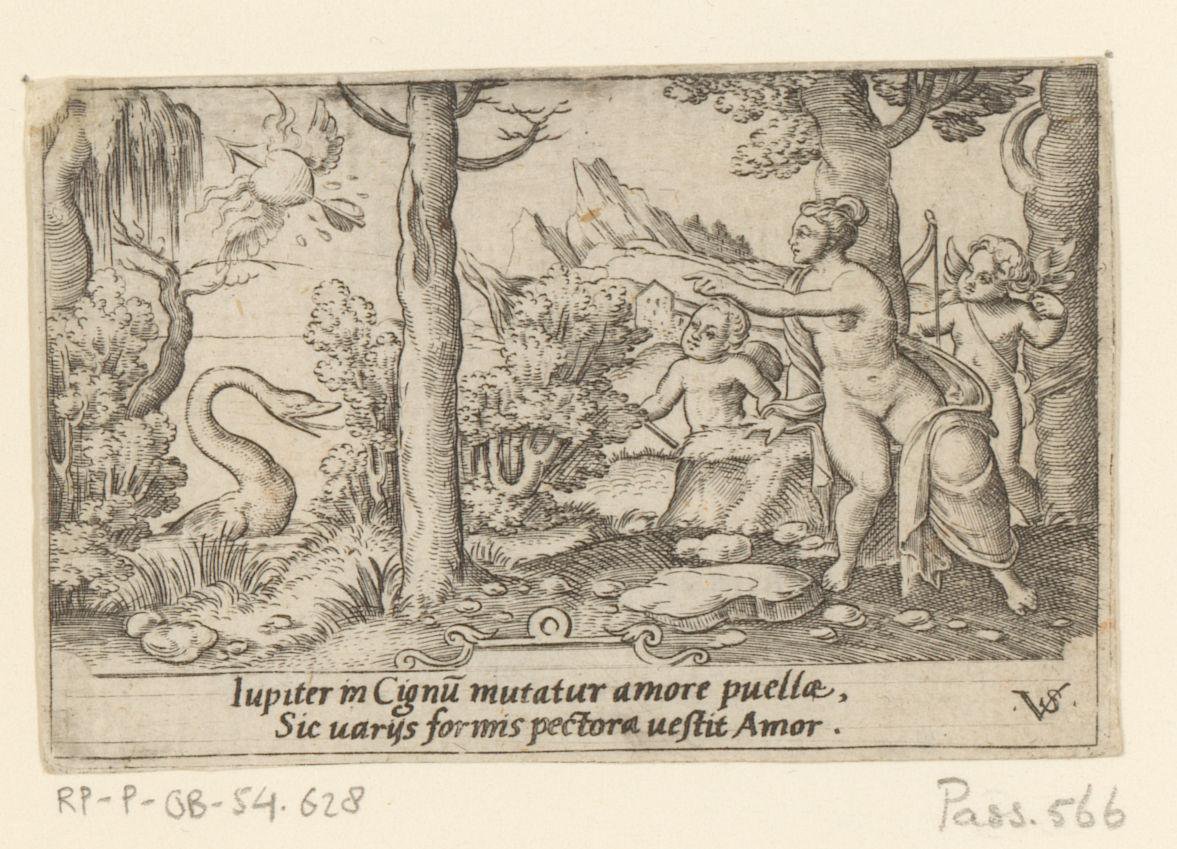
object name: print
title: Mythologische scènes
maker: virgilius solis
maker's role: draughtsman, print maker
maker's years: 1514-1562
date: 1524-1562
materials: paper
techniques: engraving, etching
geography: nuremberg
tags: jupiter, in the shape of a swan, and leda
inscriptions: collector's mark: Lugt 2228, number: ‘68’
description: Deze prent maakt deel uit van een serie van ten minste vier prenten met mythologische scènes.